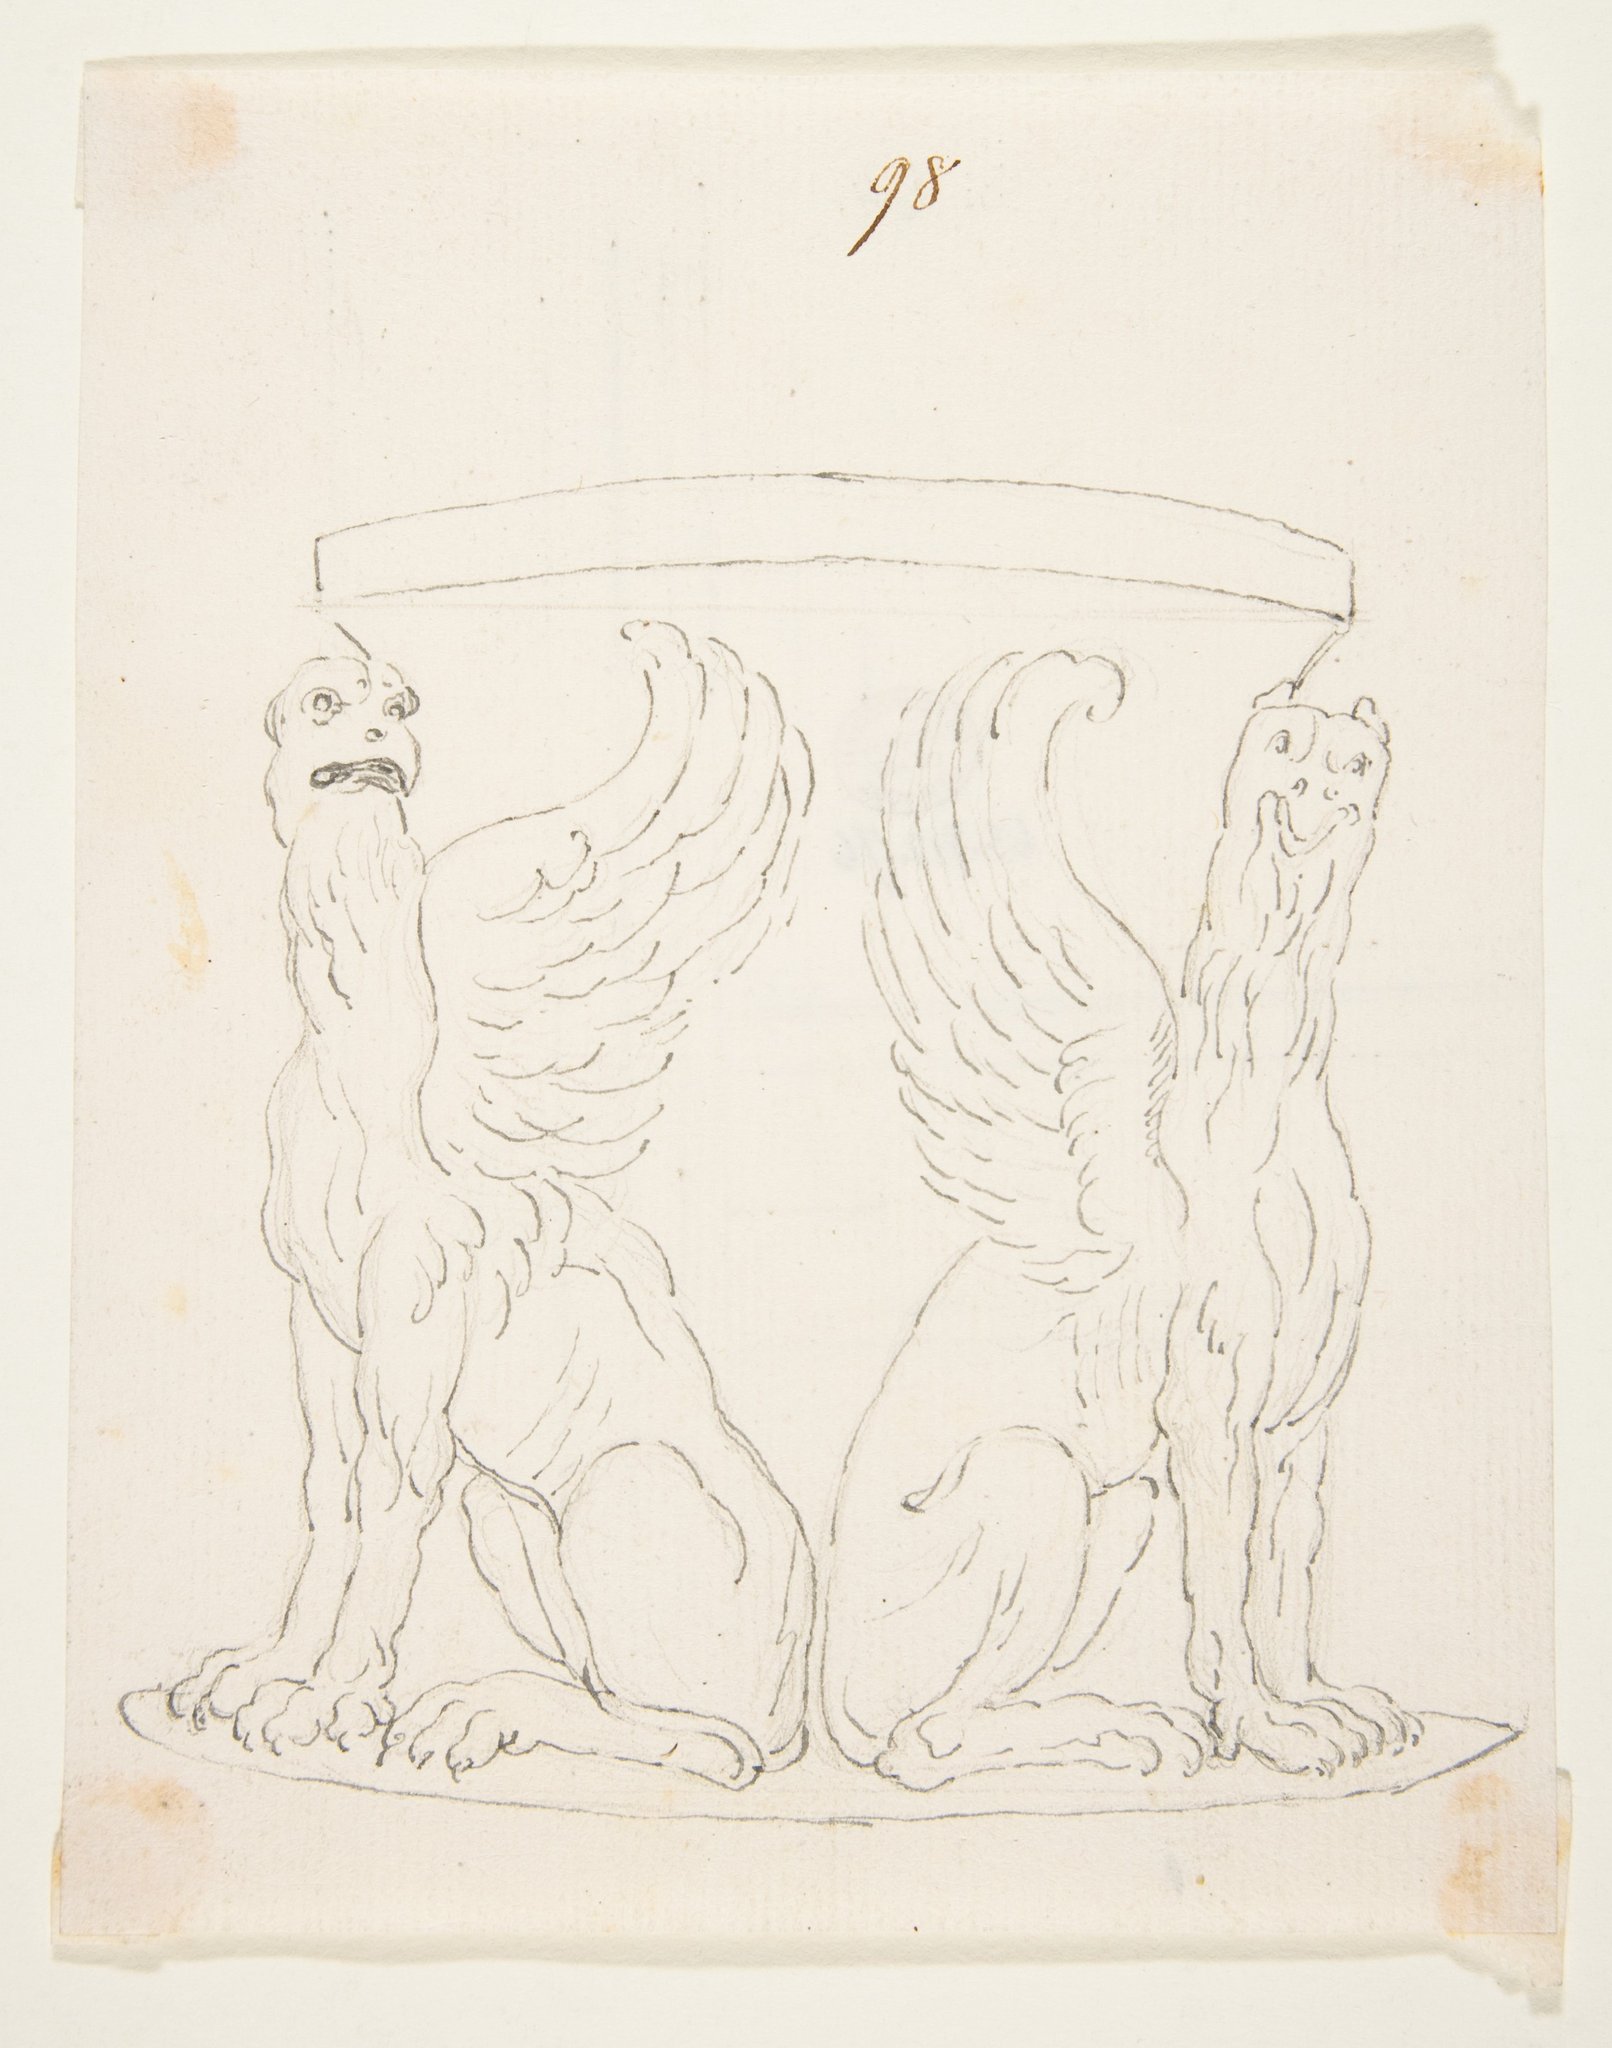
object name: drawing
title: Design for a Vessel with Two Griffons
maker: anonymous, french, 18th century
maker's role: artist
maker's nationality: french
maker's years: 1700-1800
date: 1701-1800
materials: graphite, ink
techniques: pen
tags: griffins